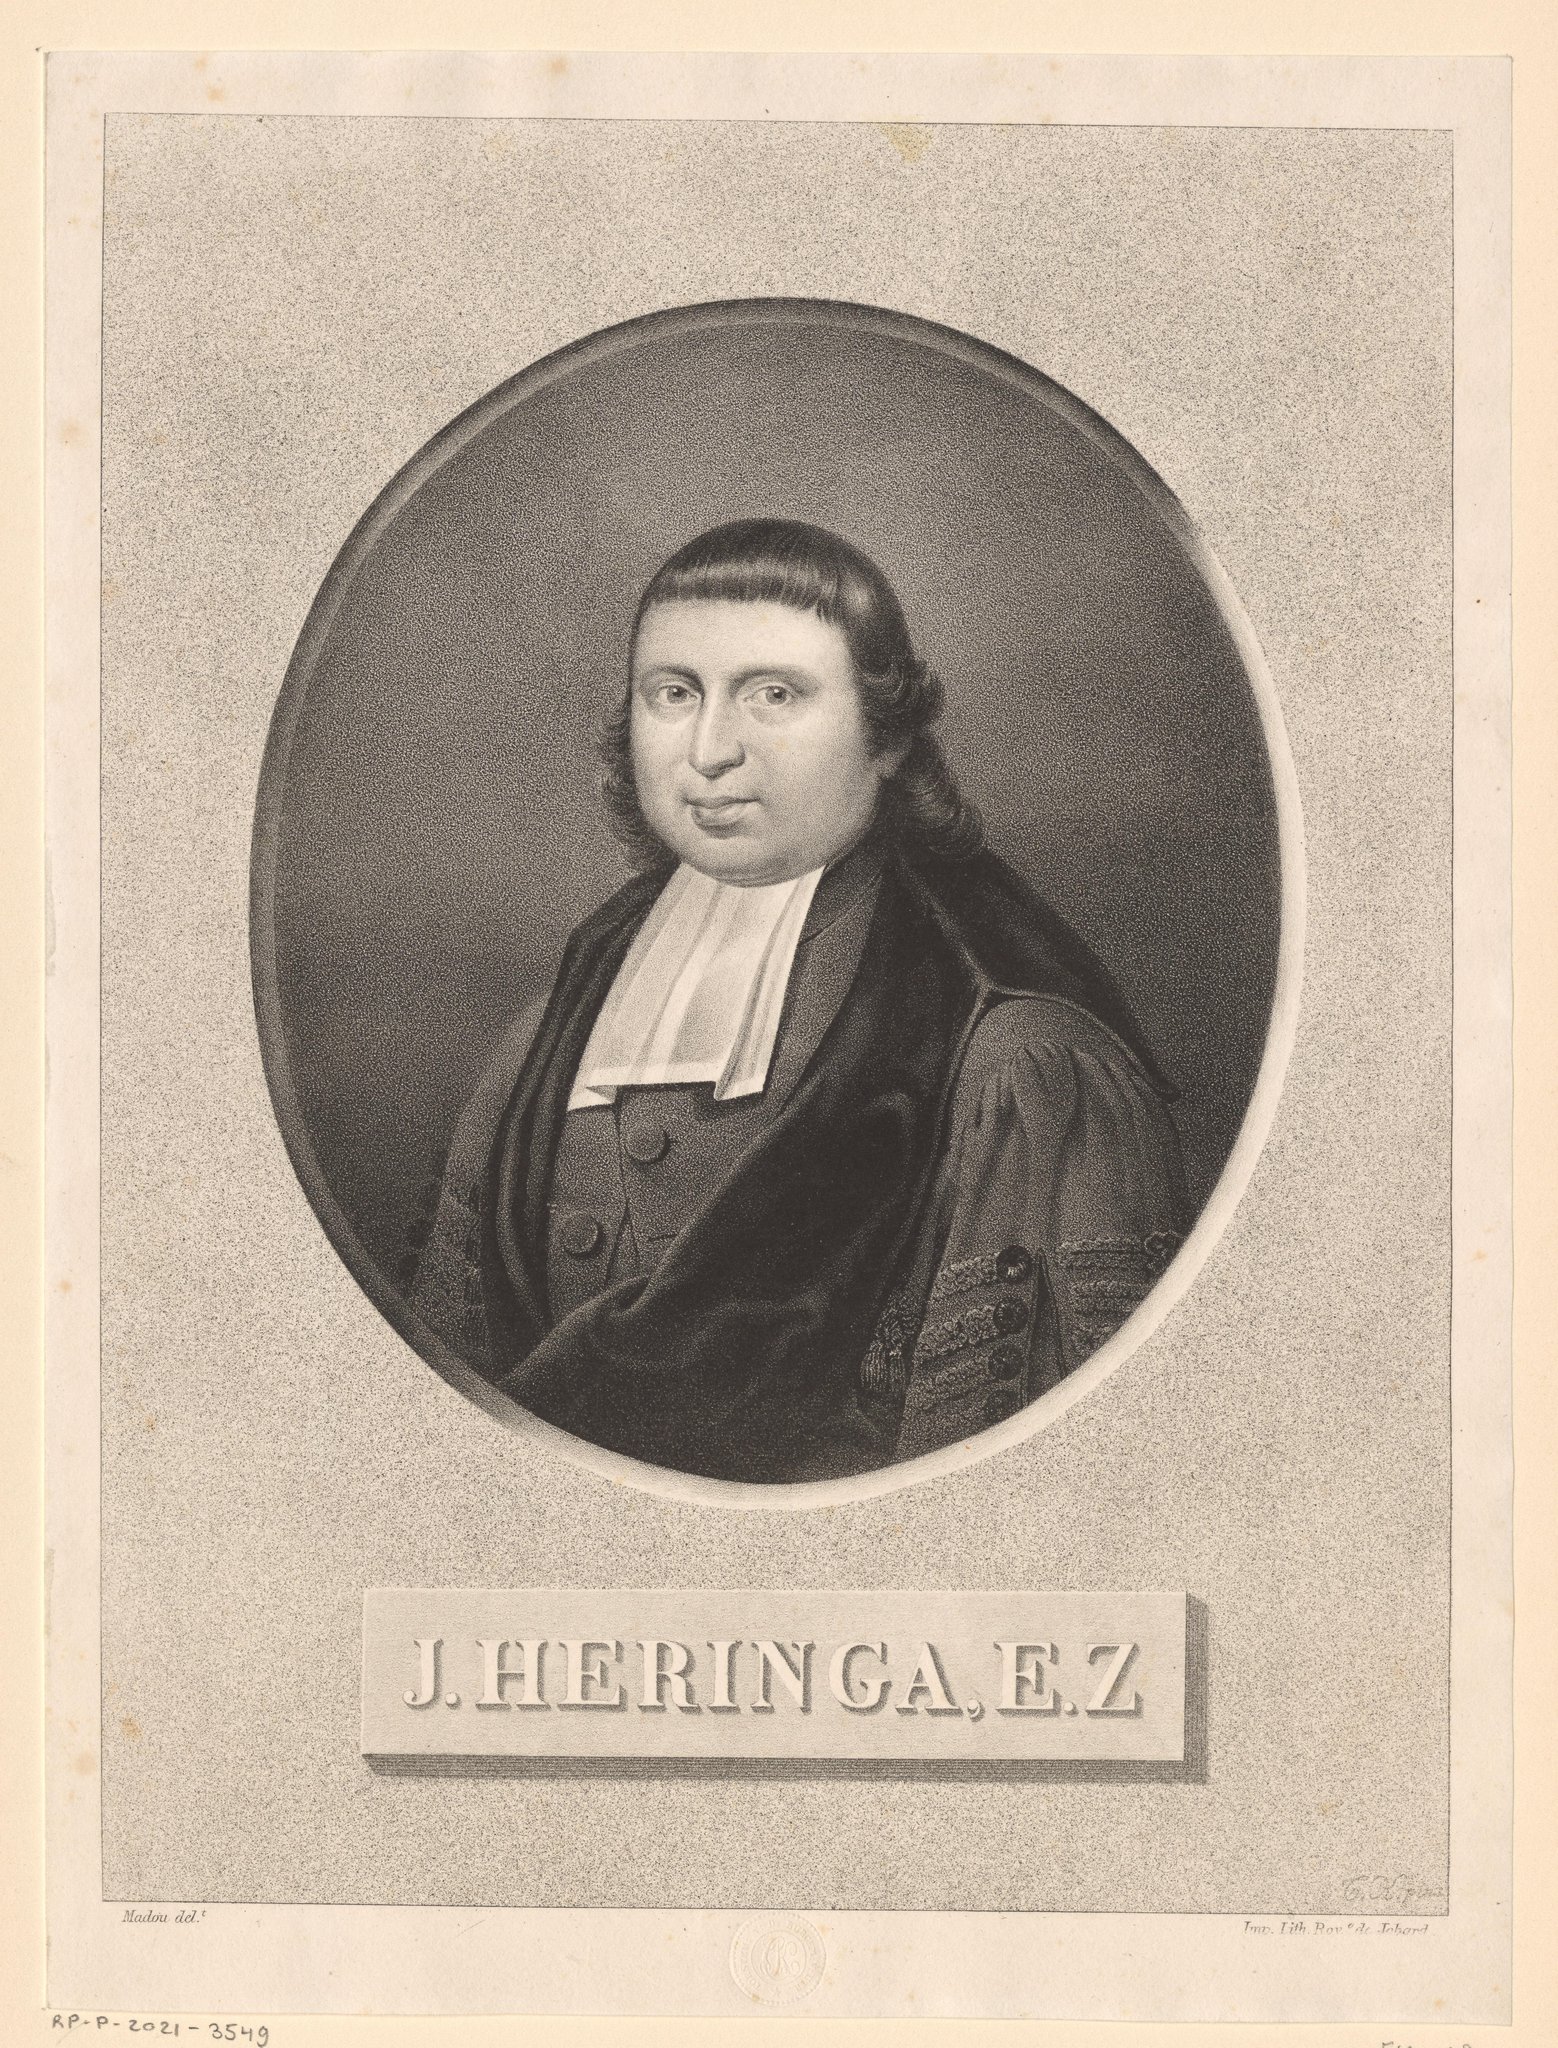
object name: print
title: Portret van Jodocus Heringa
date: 1820-1853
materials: paper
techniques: lithograph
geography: brussels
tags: utrecht, historical persons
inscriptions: check stamp: ‘Toestem[ming] v[an] d[e] burgem[eester] v[an] Utr[echt]’